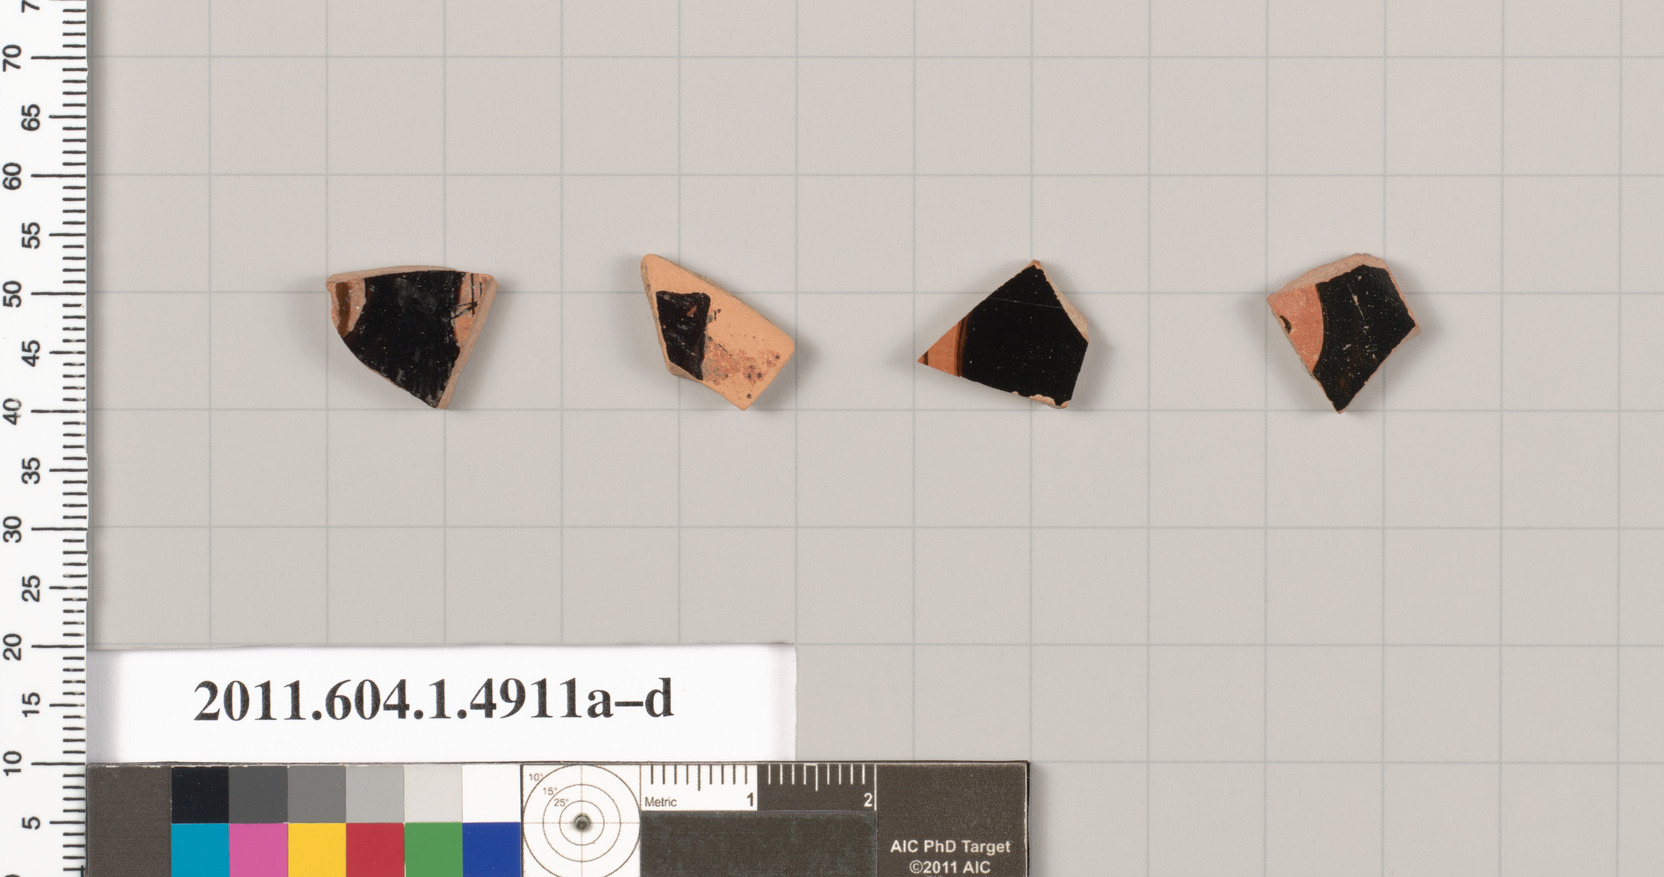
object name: kylix fragment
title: Terracotta fragments of kylikes (drinking cups)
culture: greek, attic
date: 600-401 BCE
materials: terracotta